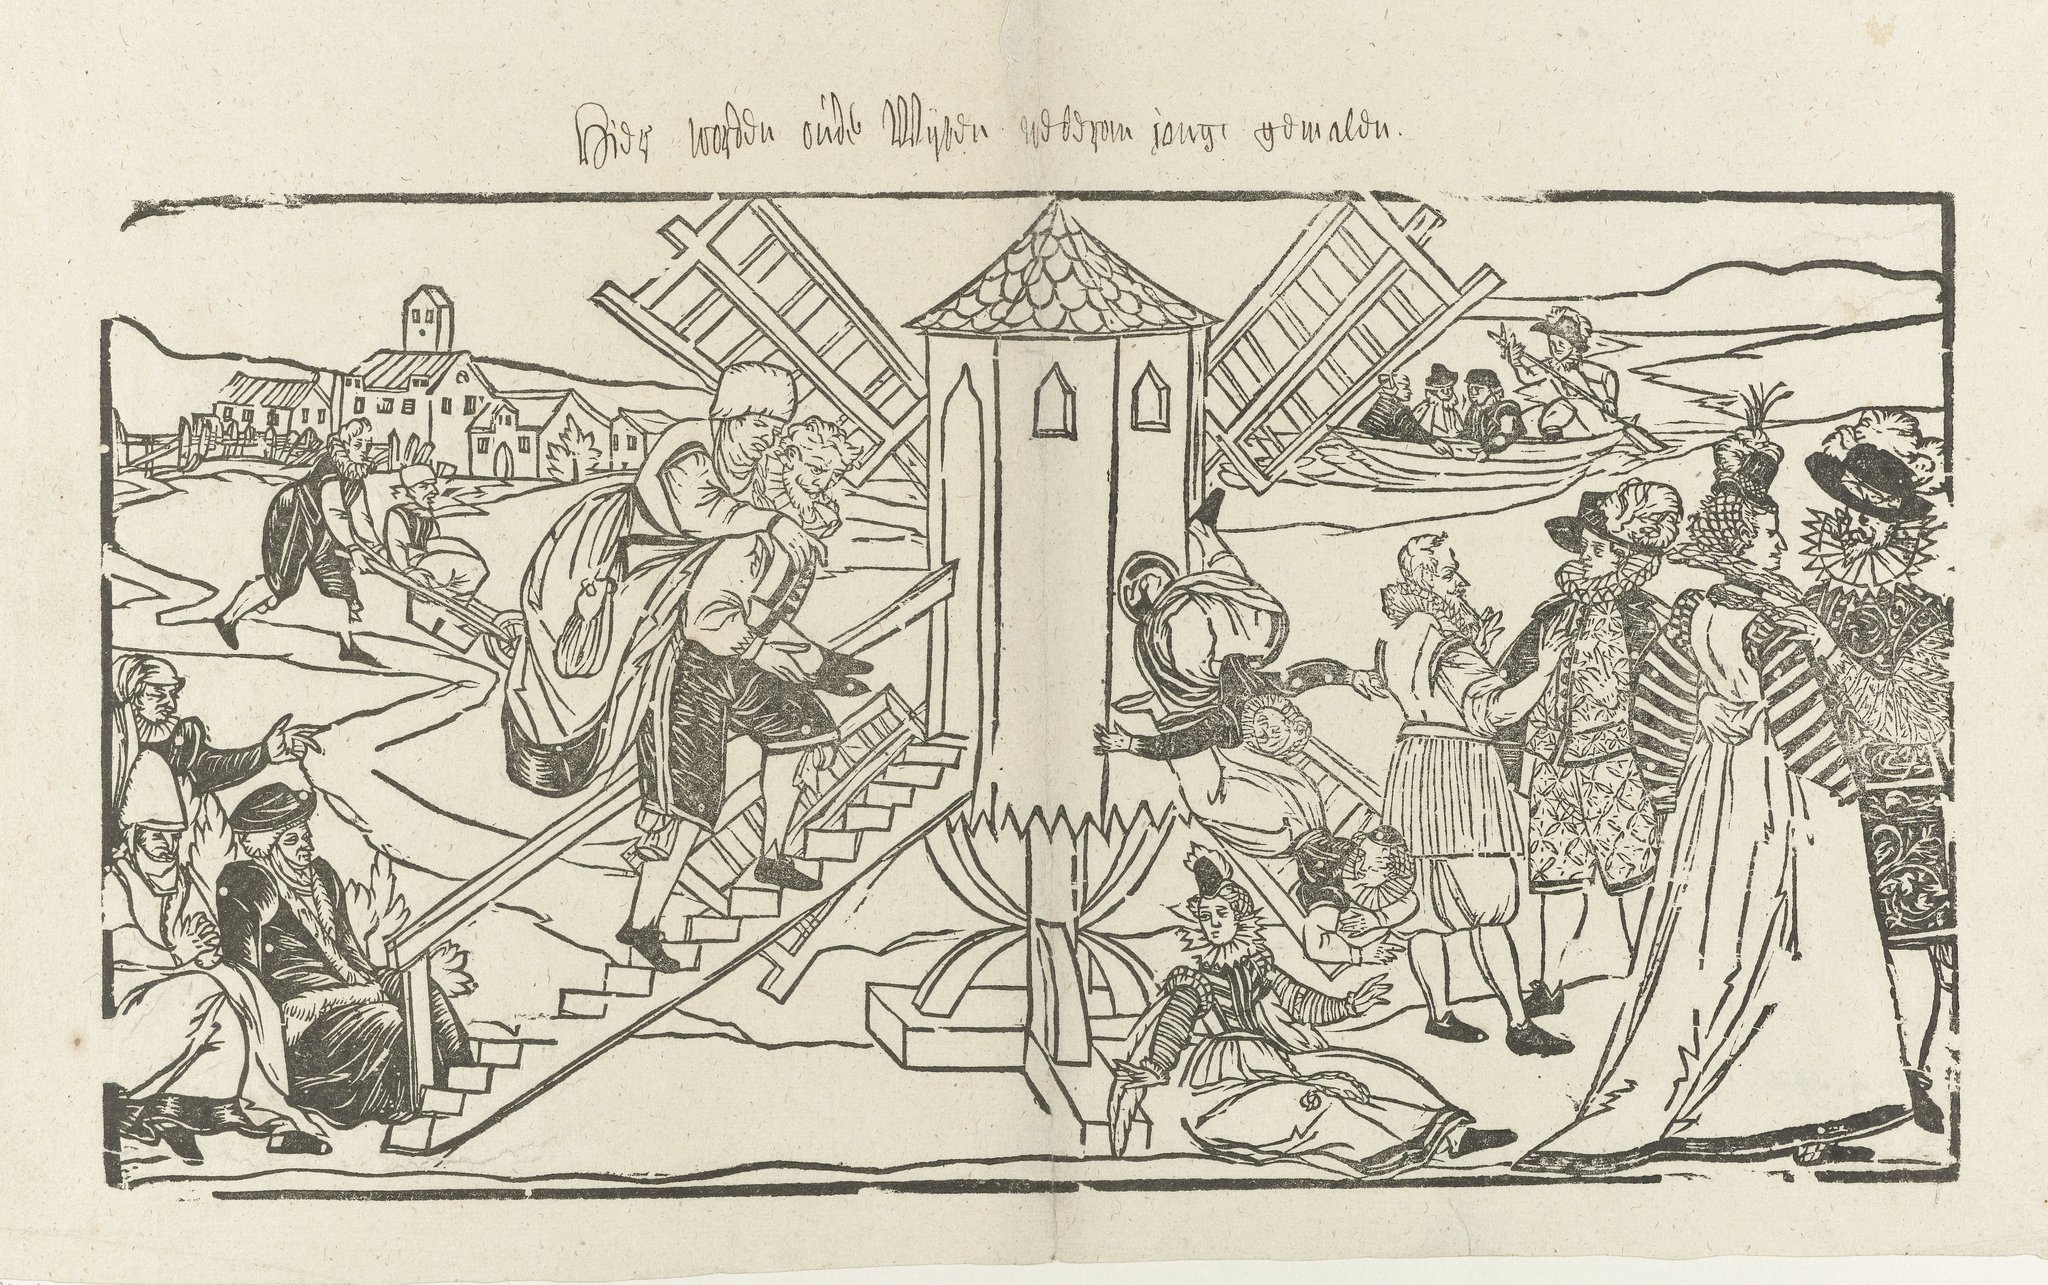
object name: print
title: Oudewijvenmolen (verjongingsmolen)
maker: Anonymous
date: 1580-1600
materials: paper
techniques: woodcut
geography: netherlands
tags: rejuvenation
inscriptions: inscription: ‘Hier worden oude wijven wedrom jong gemalen’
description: In het midden een malende molen waarin links oude vrouwen naar binnen worden gedragen. Rechts komen ze er verjongd weer uit. Links op de voorgrond drie oude vrouwen, zittend op de grond. Een man draagt een oude vrouw op zijn rug de trap op. Op de achtergrond wordt een oude vrouw in een kruiwagen aangereden. Rechts elegant geklede jonge vrouwen die uit de molen vallen met naast hen twee discussiërende mannen. Op de voorgrond een elegant gekleed stel. Rechts op de achtergrond een gezelschap in een bootje.